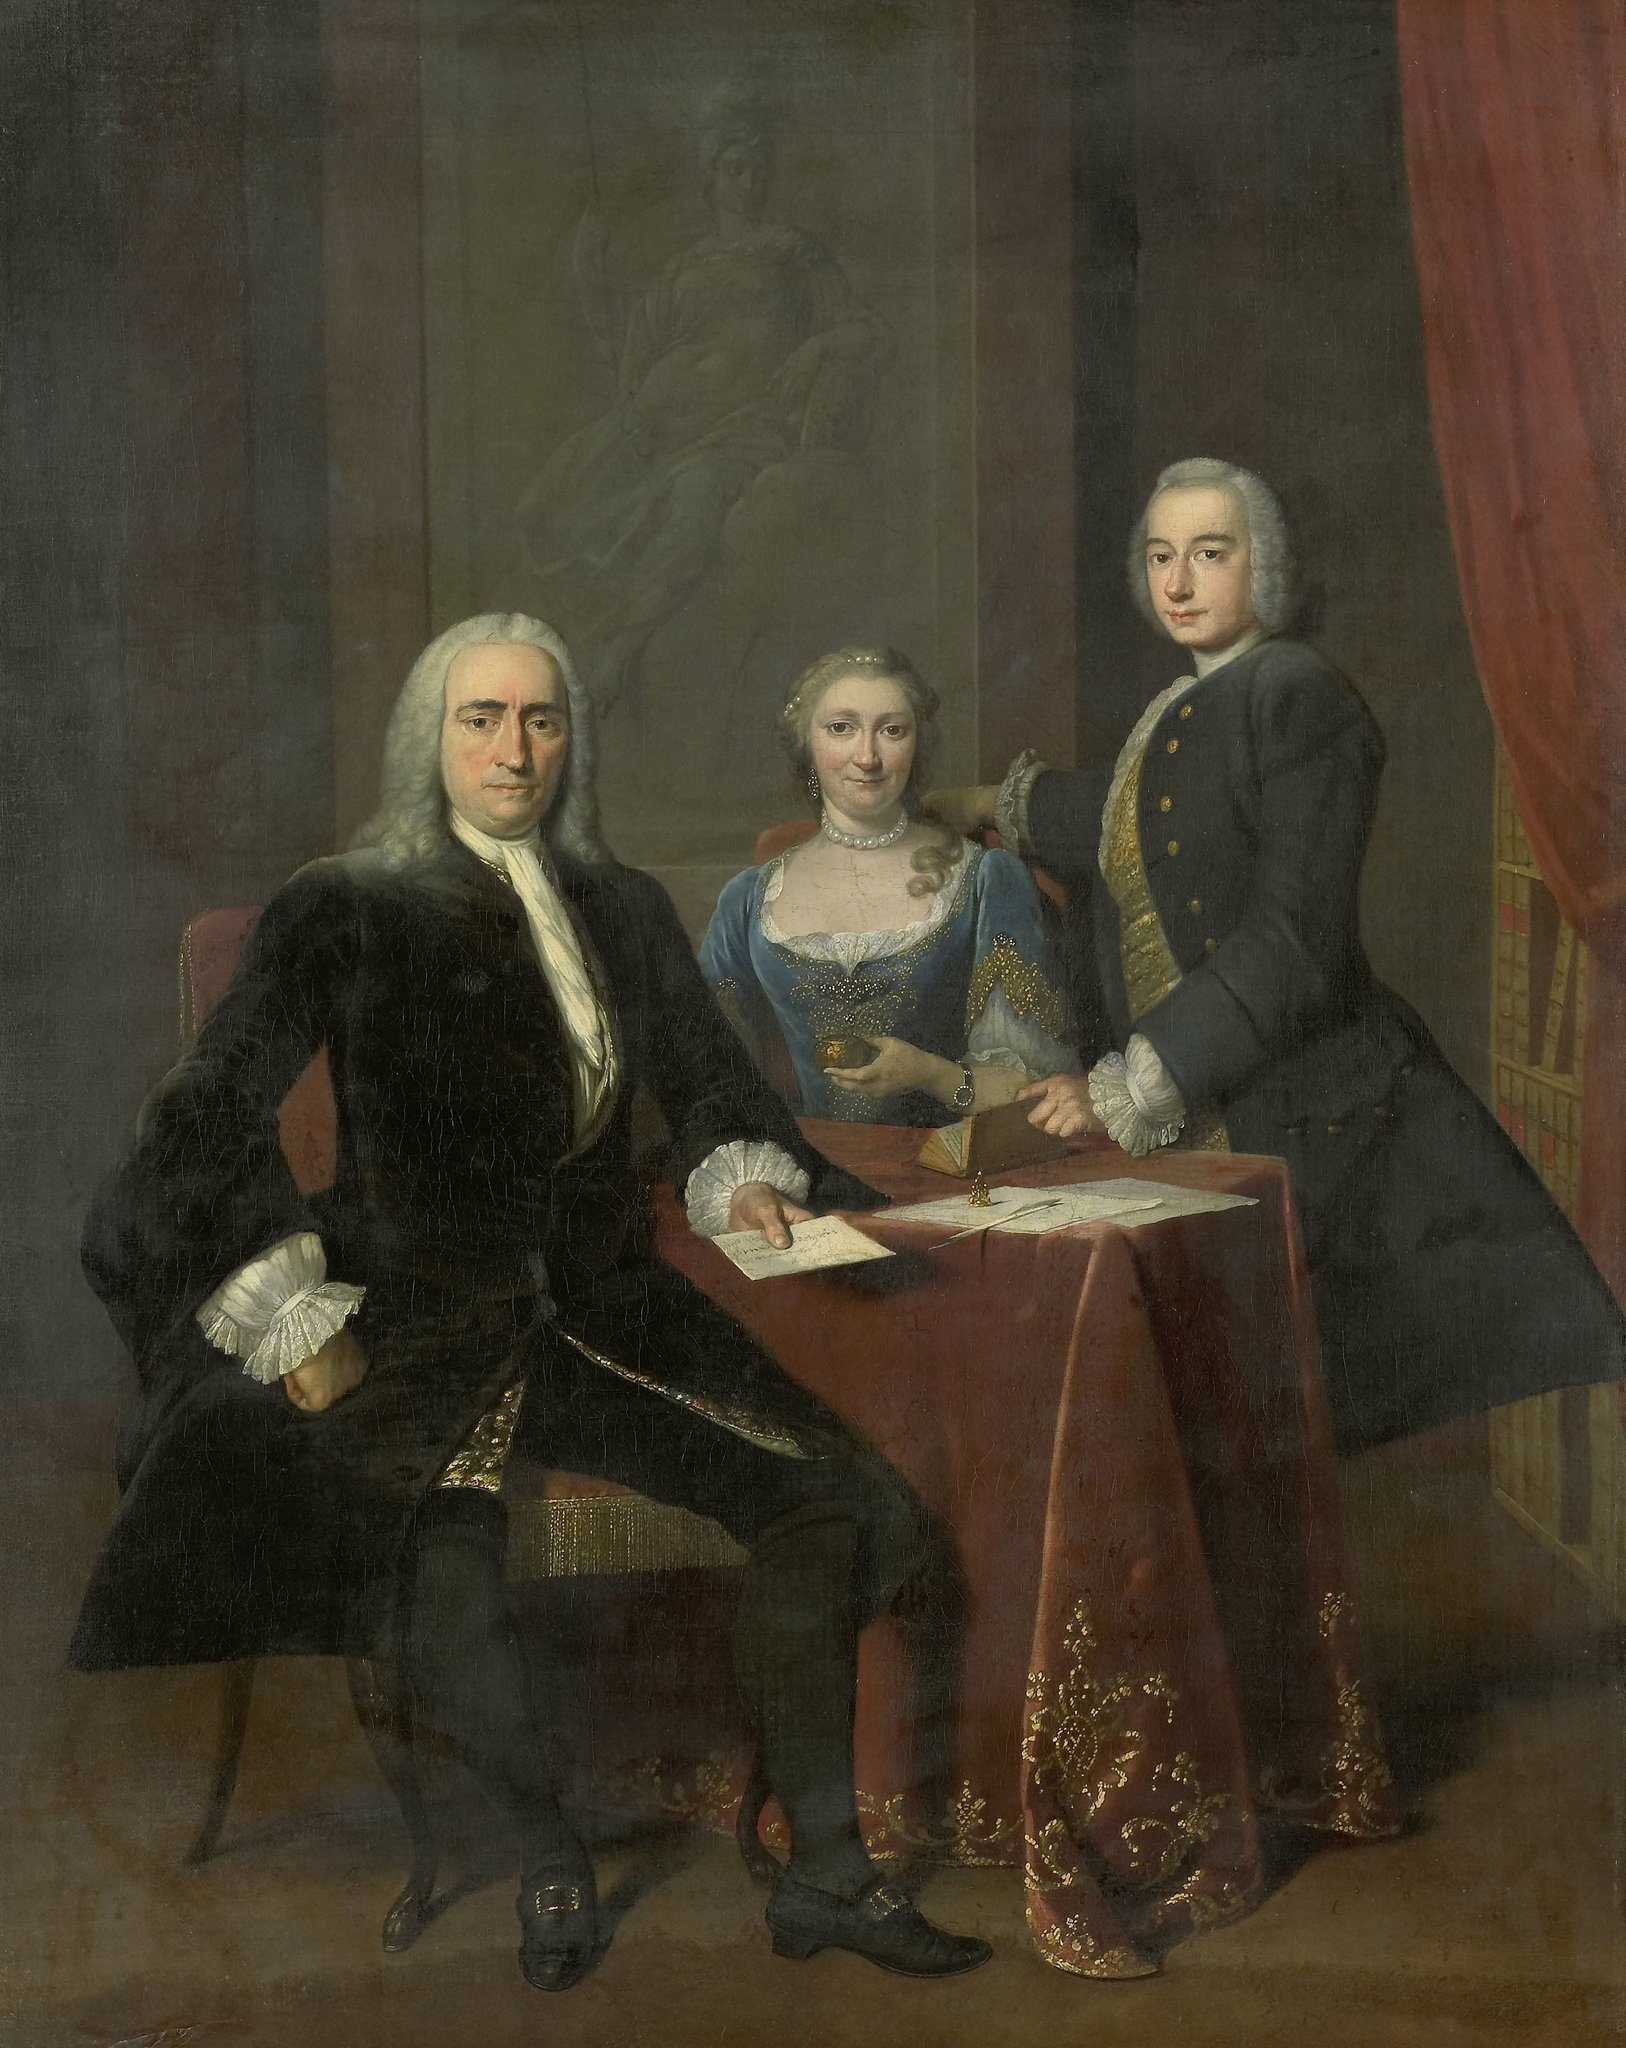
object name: painting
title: Family Group in an Interior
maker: frans van der mijn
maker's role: painter, print maker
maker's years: 1719-1783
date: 1744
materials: canvas, oil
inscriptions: signature and date: ‘F. Van der Mijn. 1744’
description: Familiegroep in een interieur. Familieportret met de ouders gezeten aan een tafel en de zoon staande met zijn hand op de schouder van zijn moeder. Op tafel een boek en enkele brieven. Rechts een boekenkast, tegen de achterwand een schildering van Minerva.